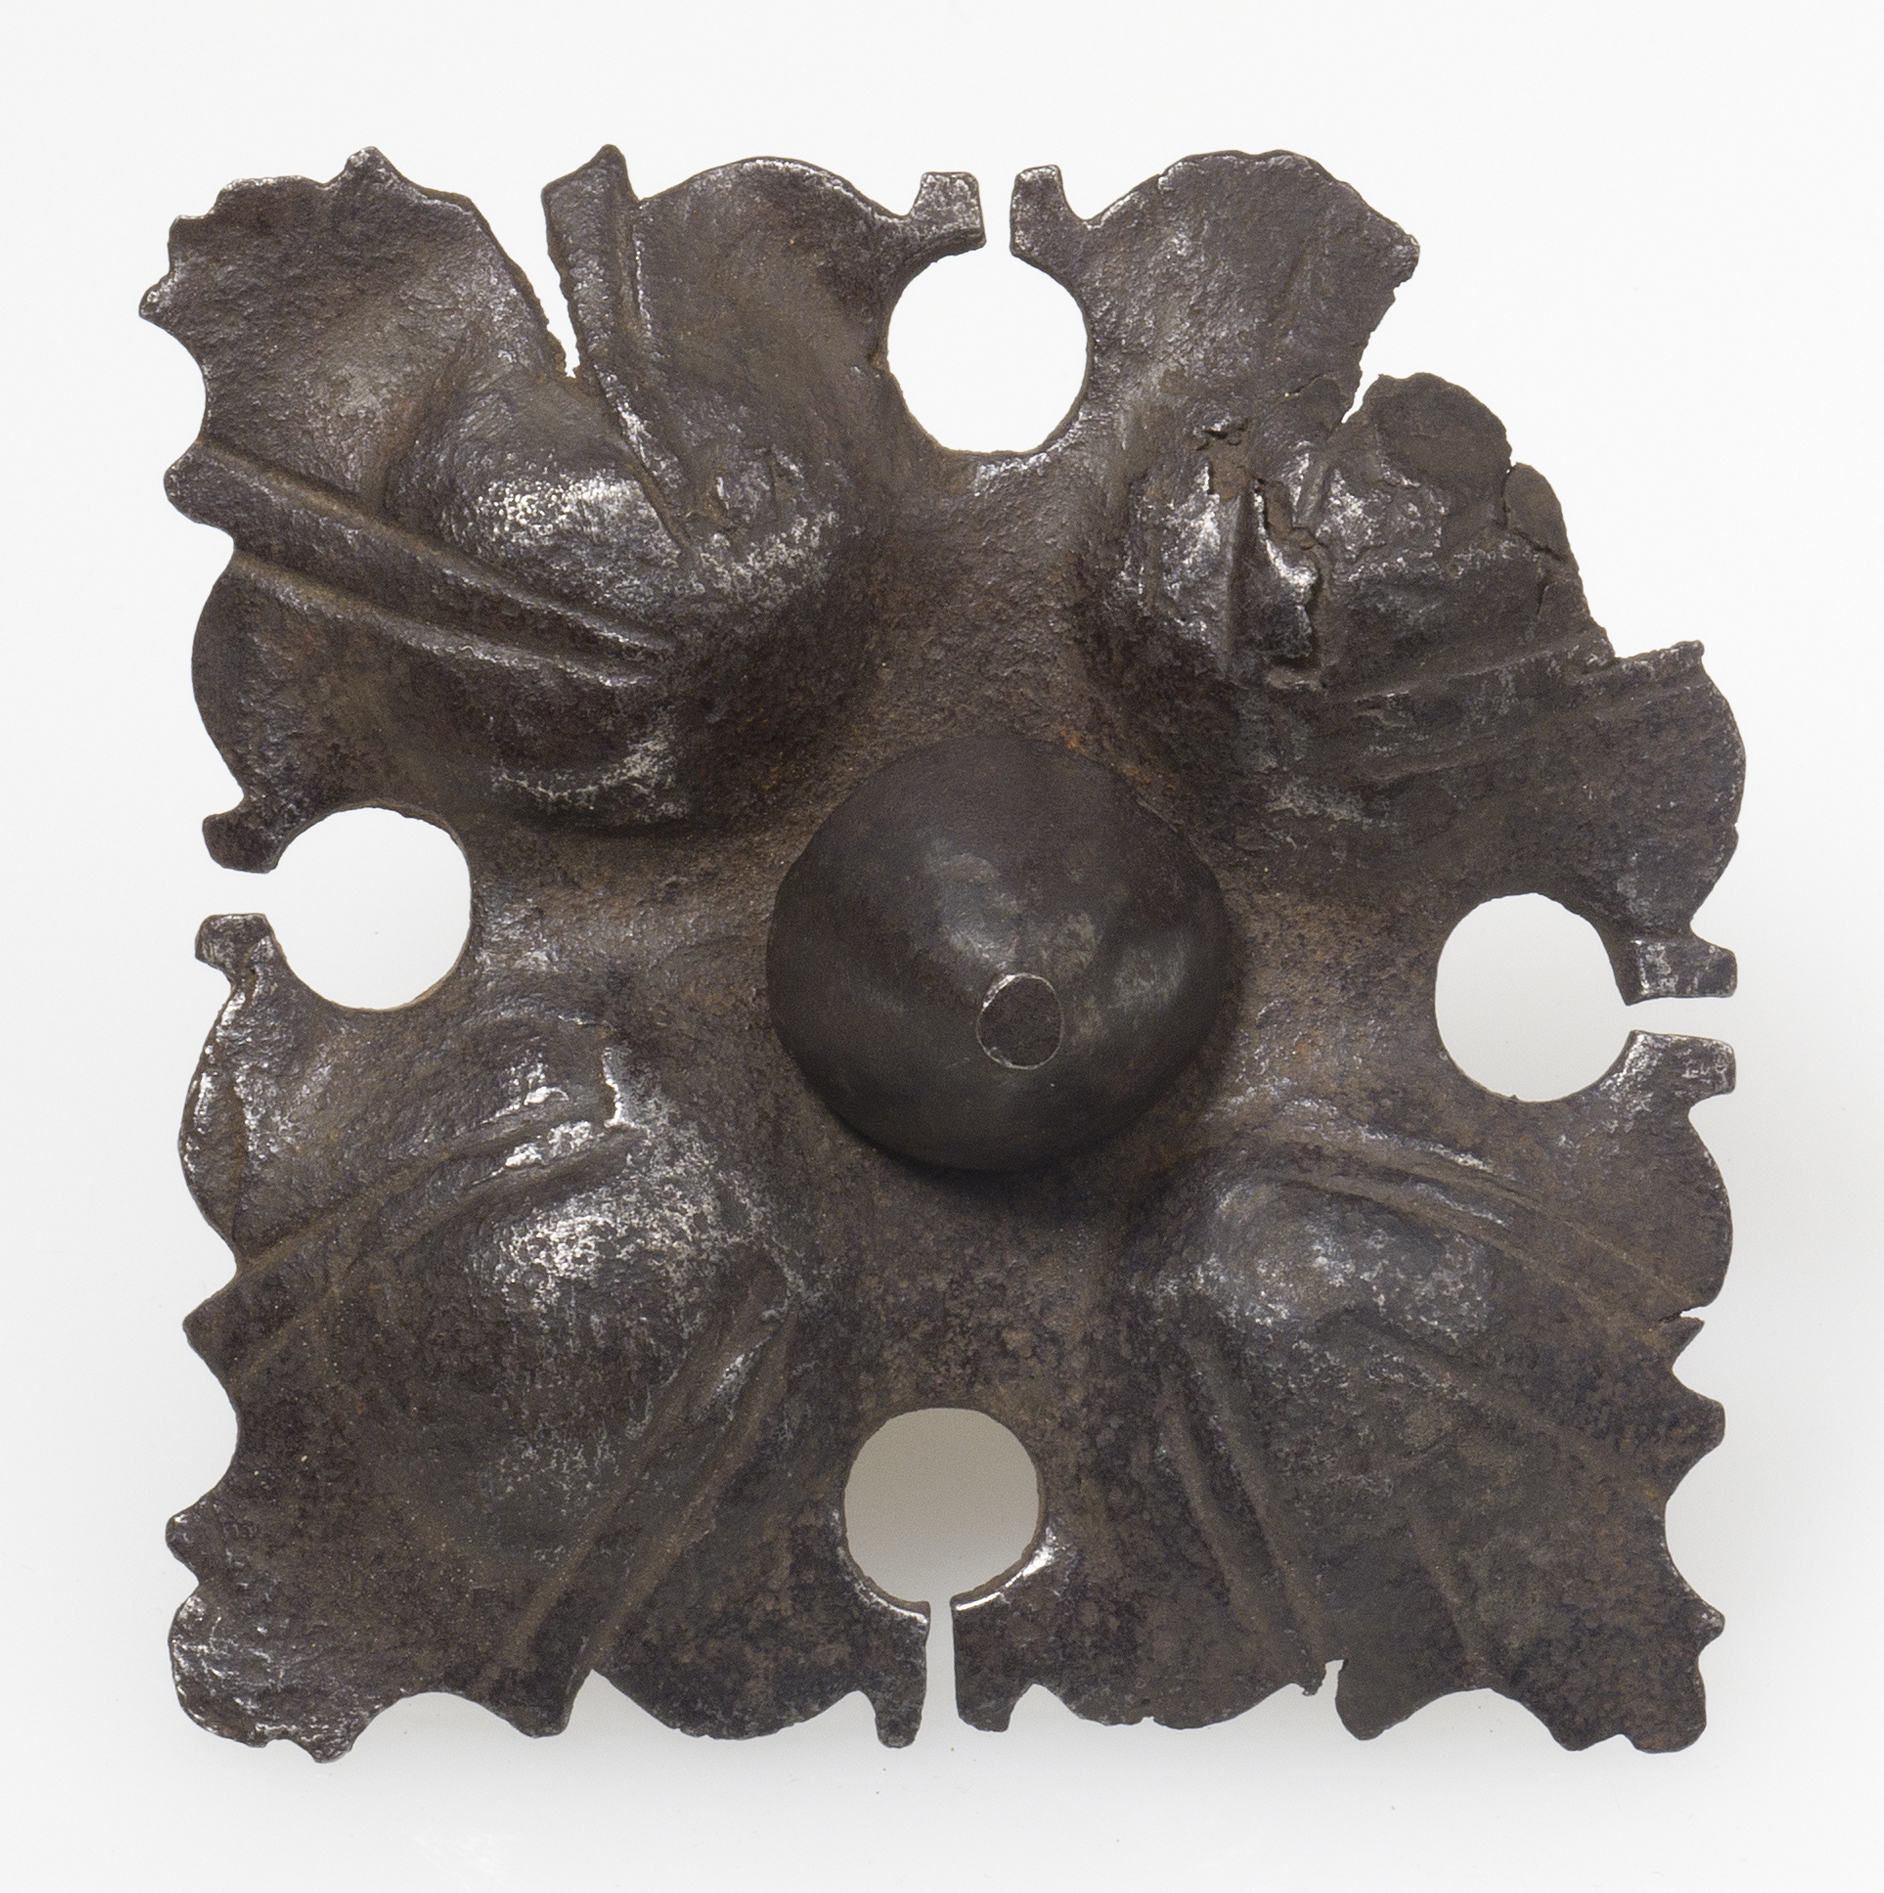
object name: plate and nail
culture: european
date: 1401-1600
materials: iron